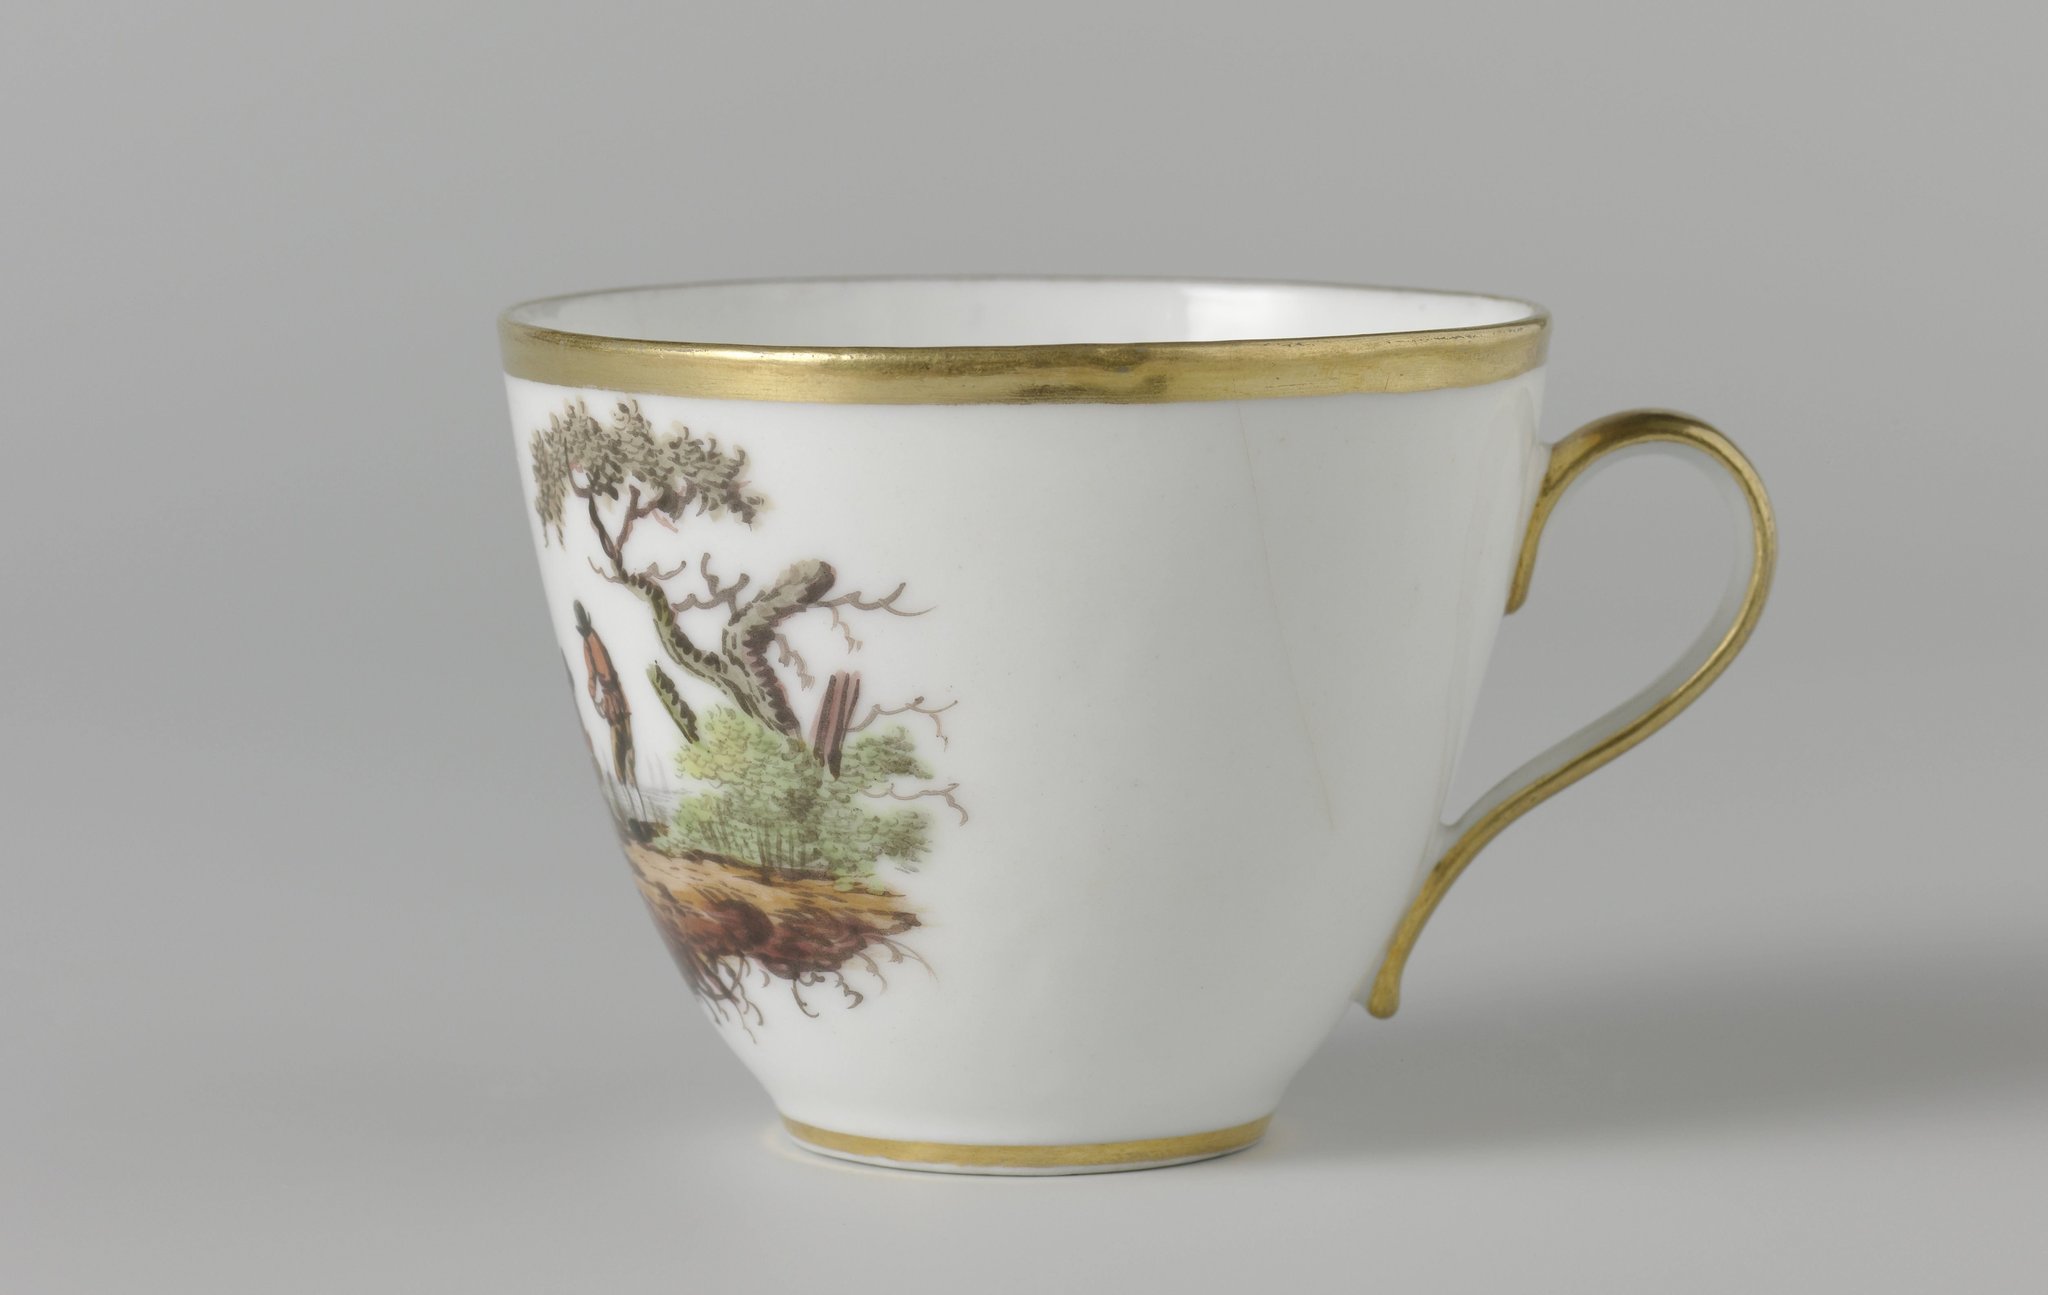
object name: kop en schotel, kop en schotel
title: Kop en schotel met riviergezicht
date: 1809-1814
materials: porcelain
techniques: painted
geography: nieuwer-amstel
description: Kop en schotel versierd met een veelkleurig landschap. Langs de randen een bladrank. Gemerkt: Amstel.